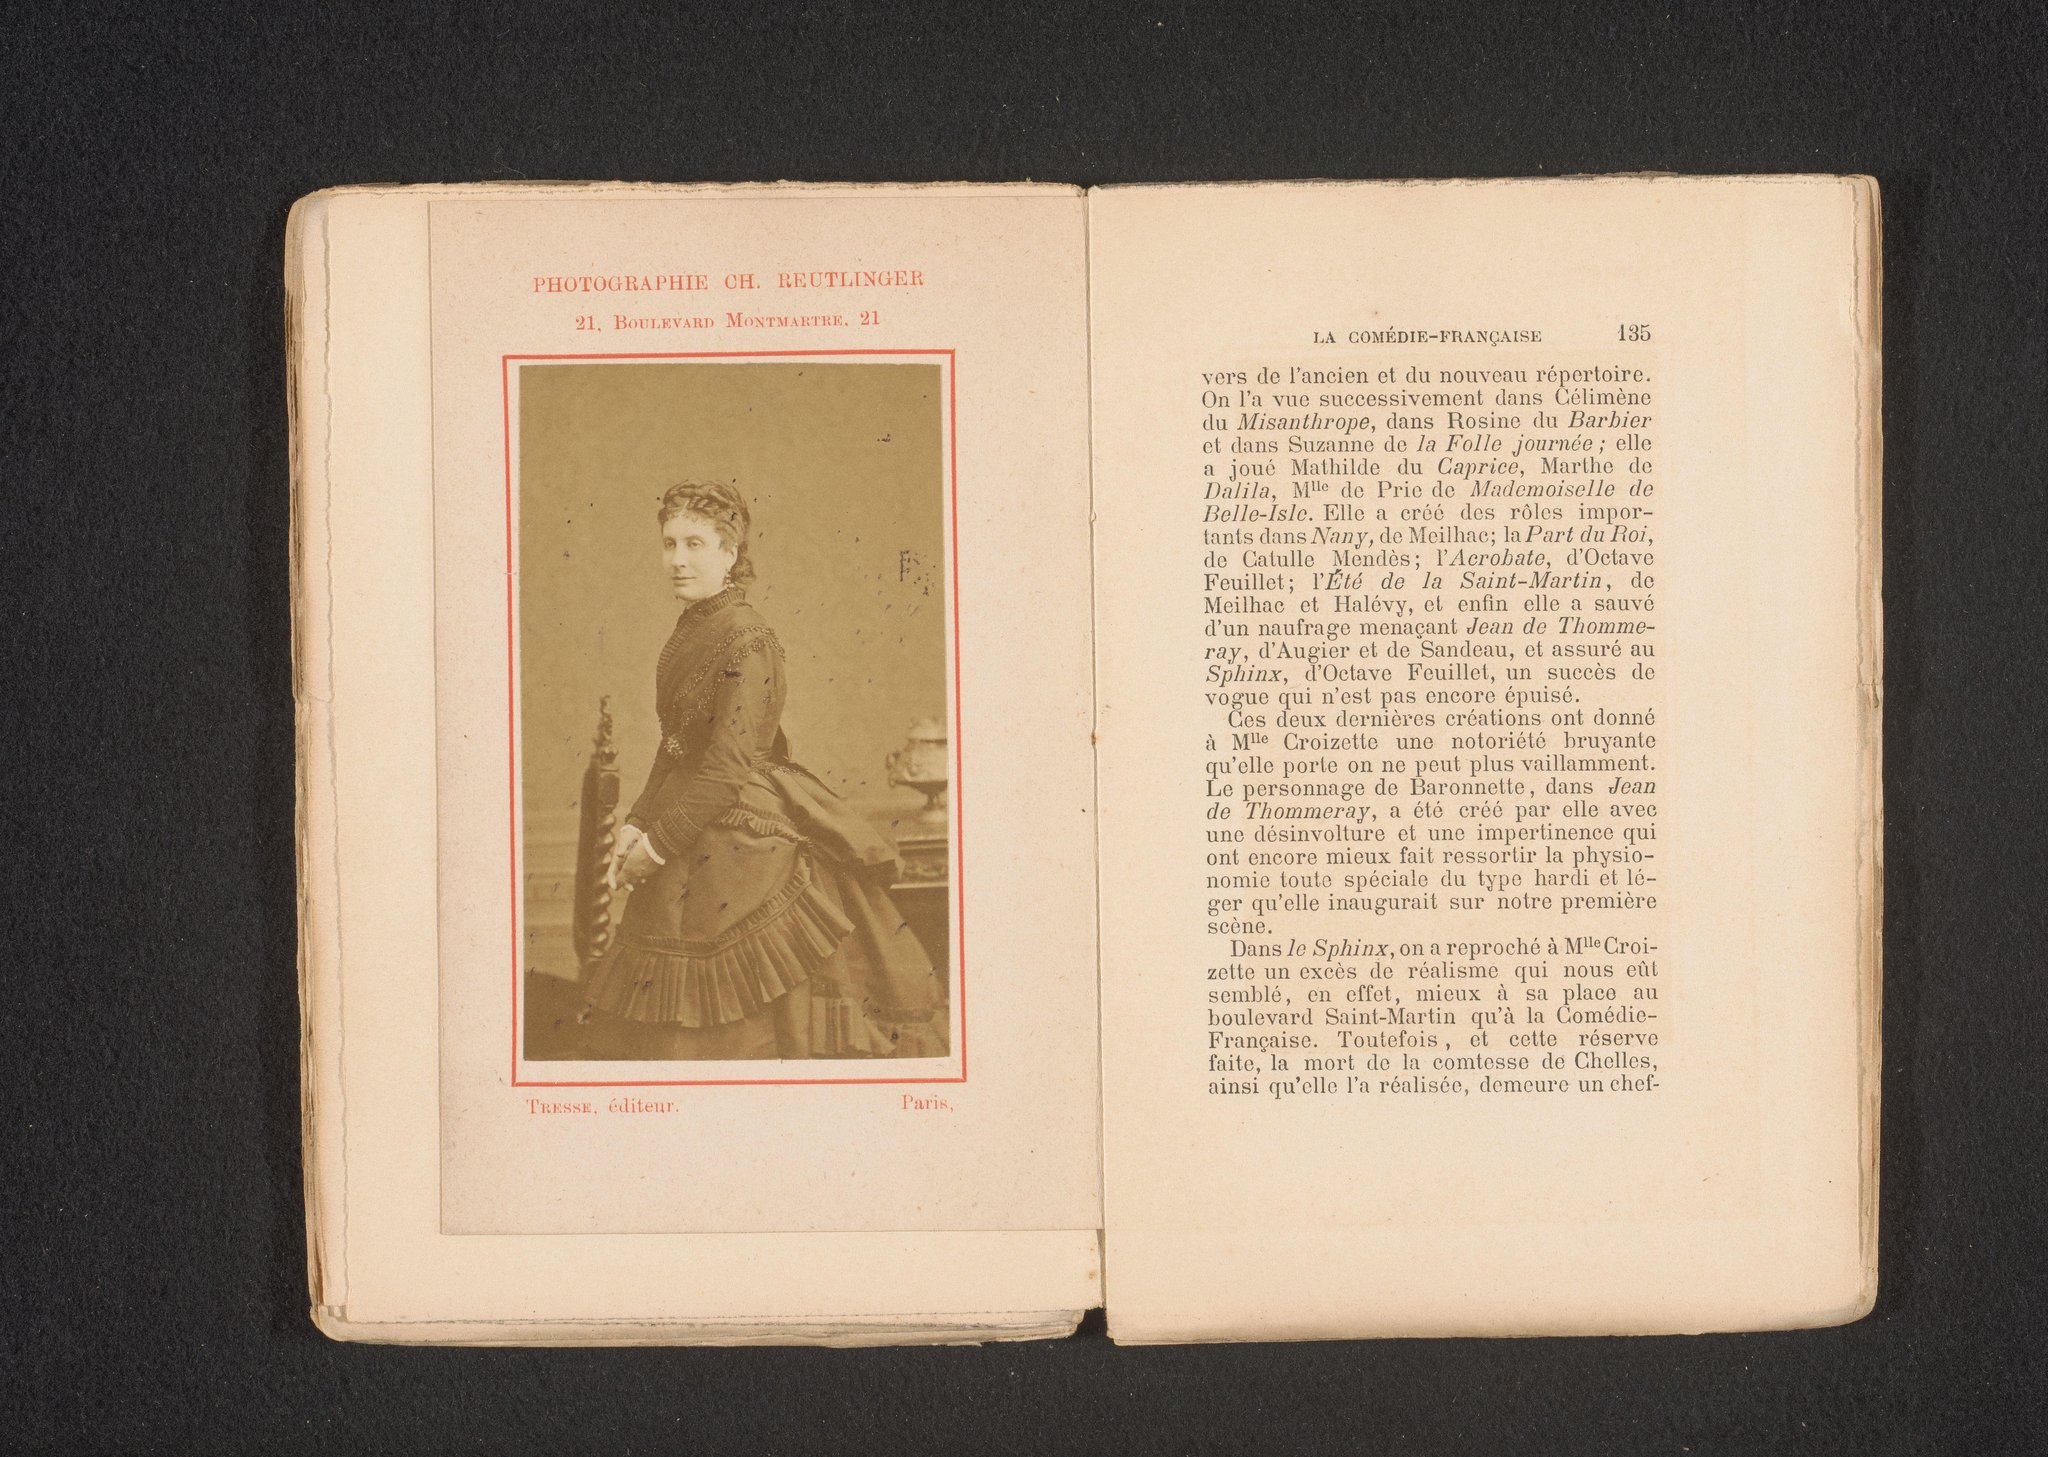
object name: page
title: Portret van Maria Favart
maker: charles reutlinger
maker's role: publisher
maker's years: 1816-1880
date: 1874-1884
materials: photographic support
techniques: albumen print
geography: paris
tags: female singer